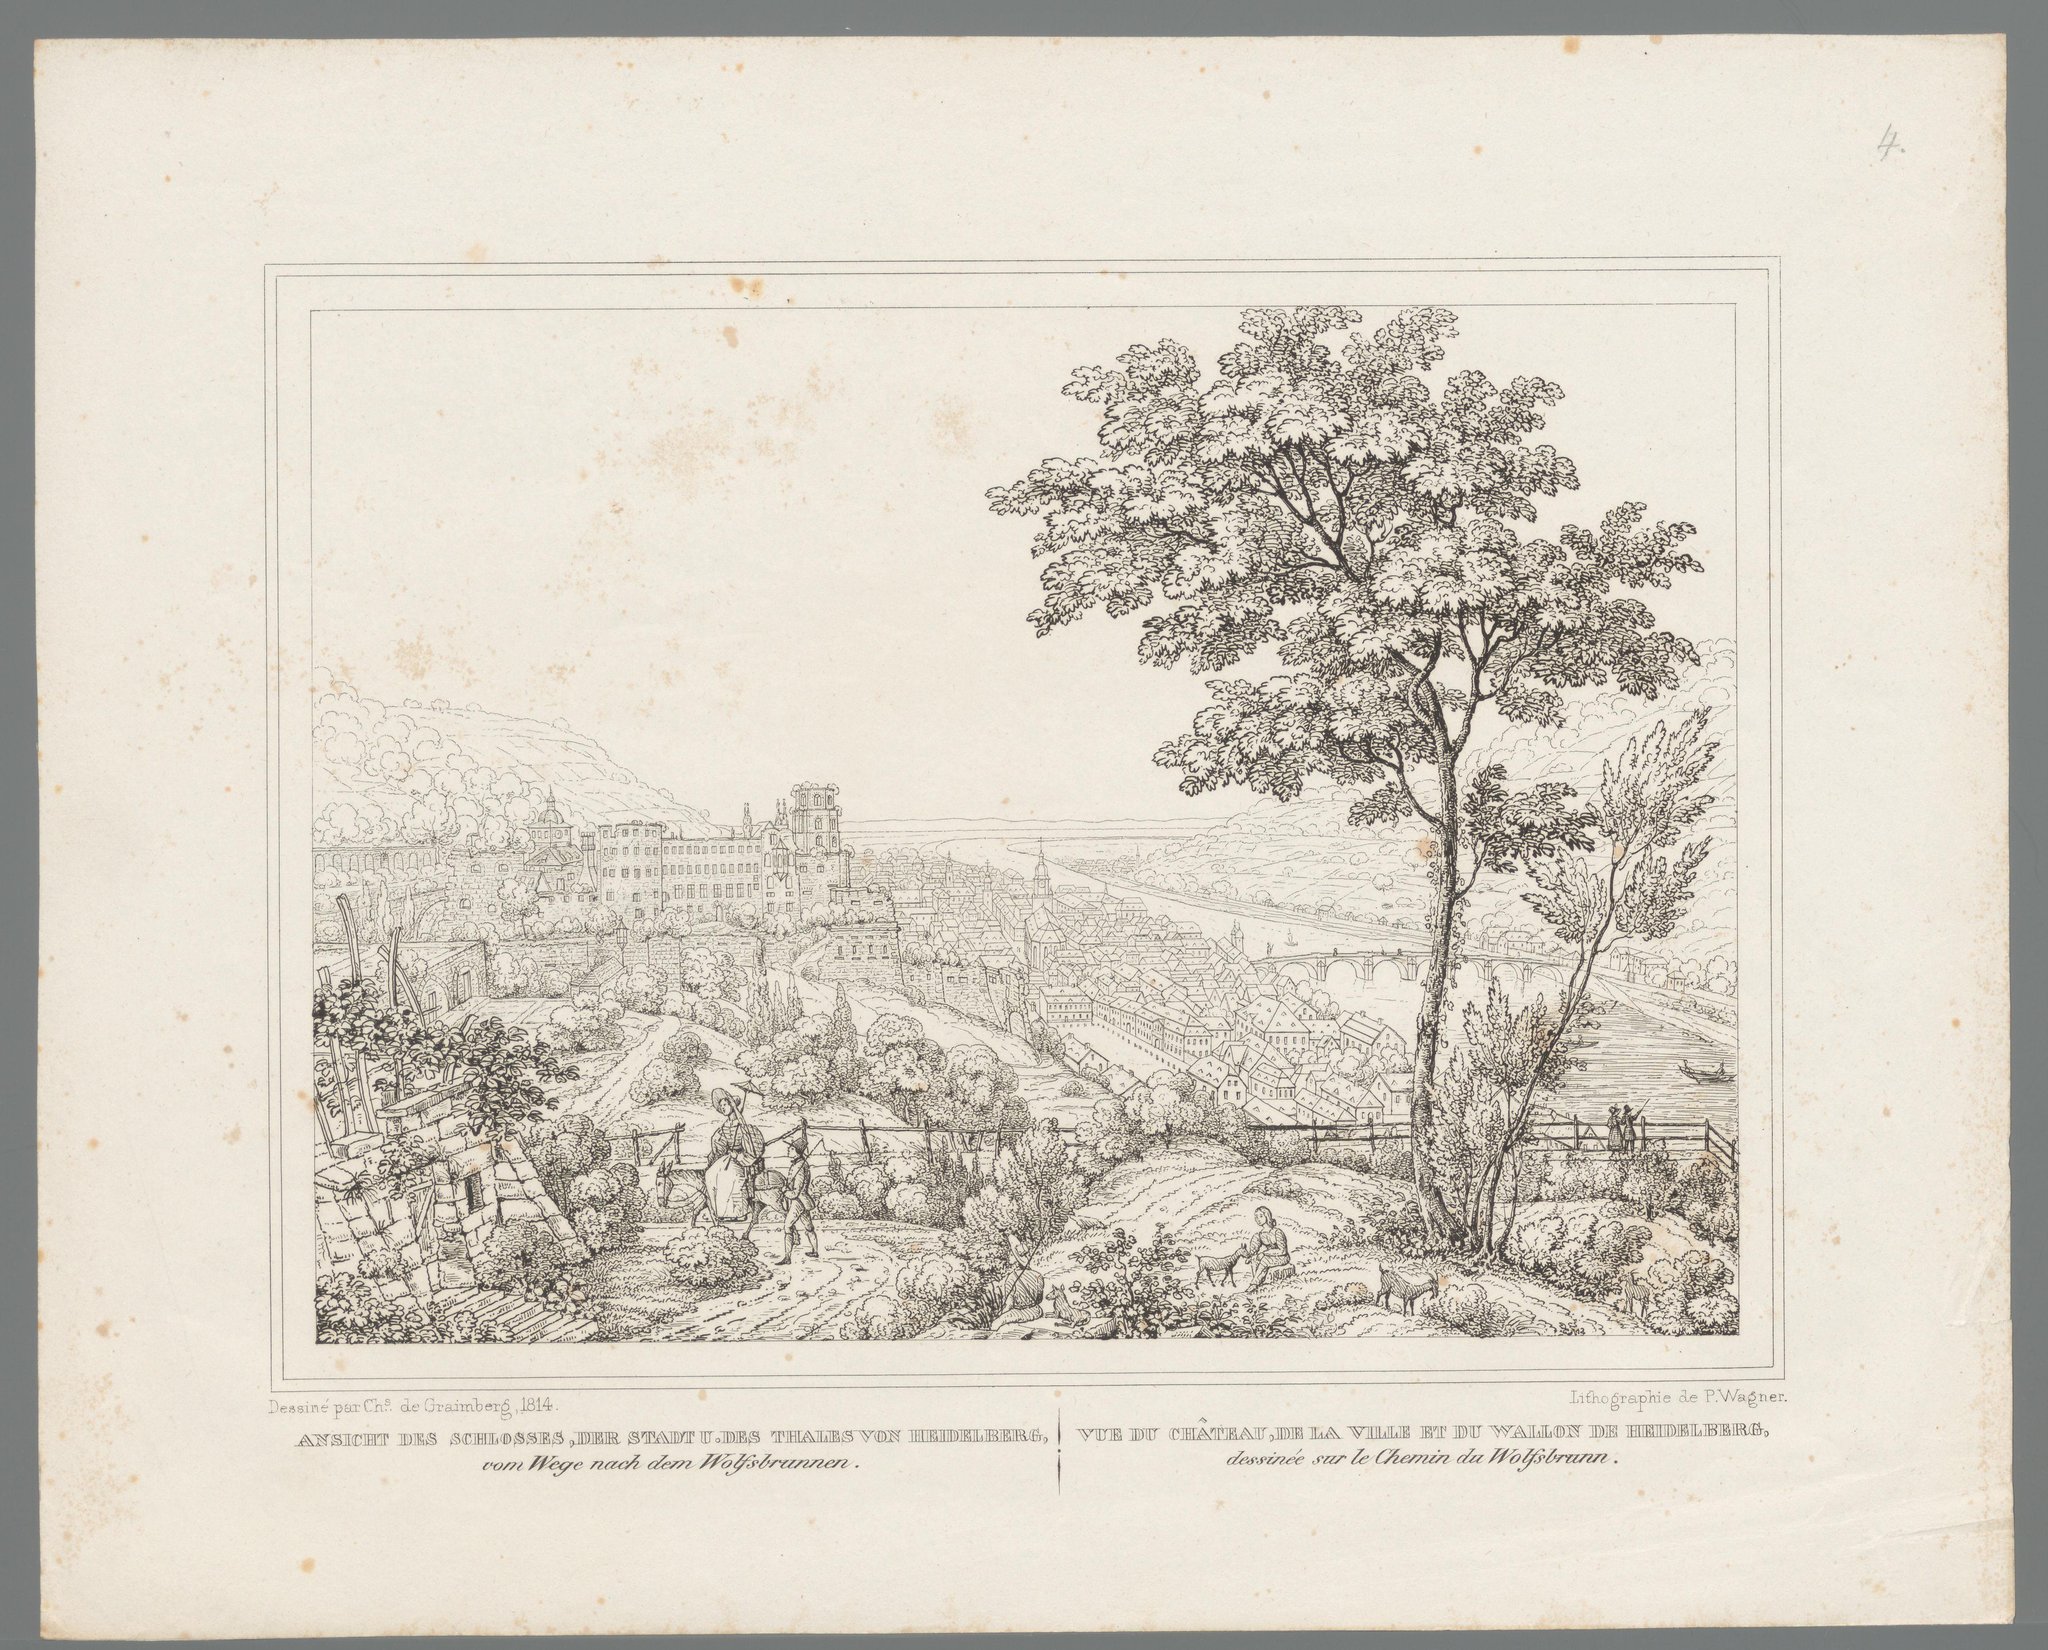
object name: print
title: Gezicht op het Heidelberger Slot en de stad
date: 1814-1830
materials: paper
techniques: lithograph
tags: palace, landscape with tower or castle (+ city(-scape) with figures, staffage)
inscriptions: collector's mark: Lugt 2233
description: Prent maakt deel uit van een serie met gezichten op het Heidelberger Slot. Over deze serie is verder niets bekend. Het betreft (ten minste) negen gezichten op het Heidelberger slot.